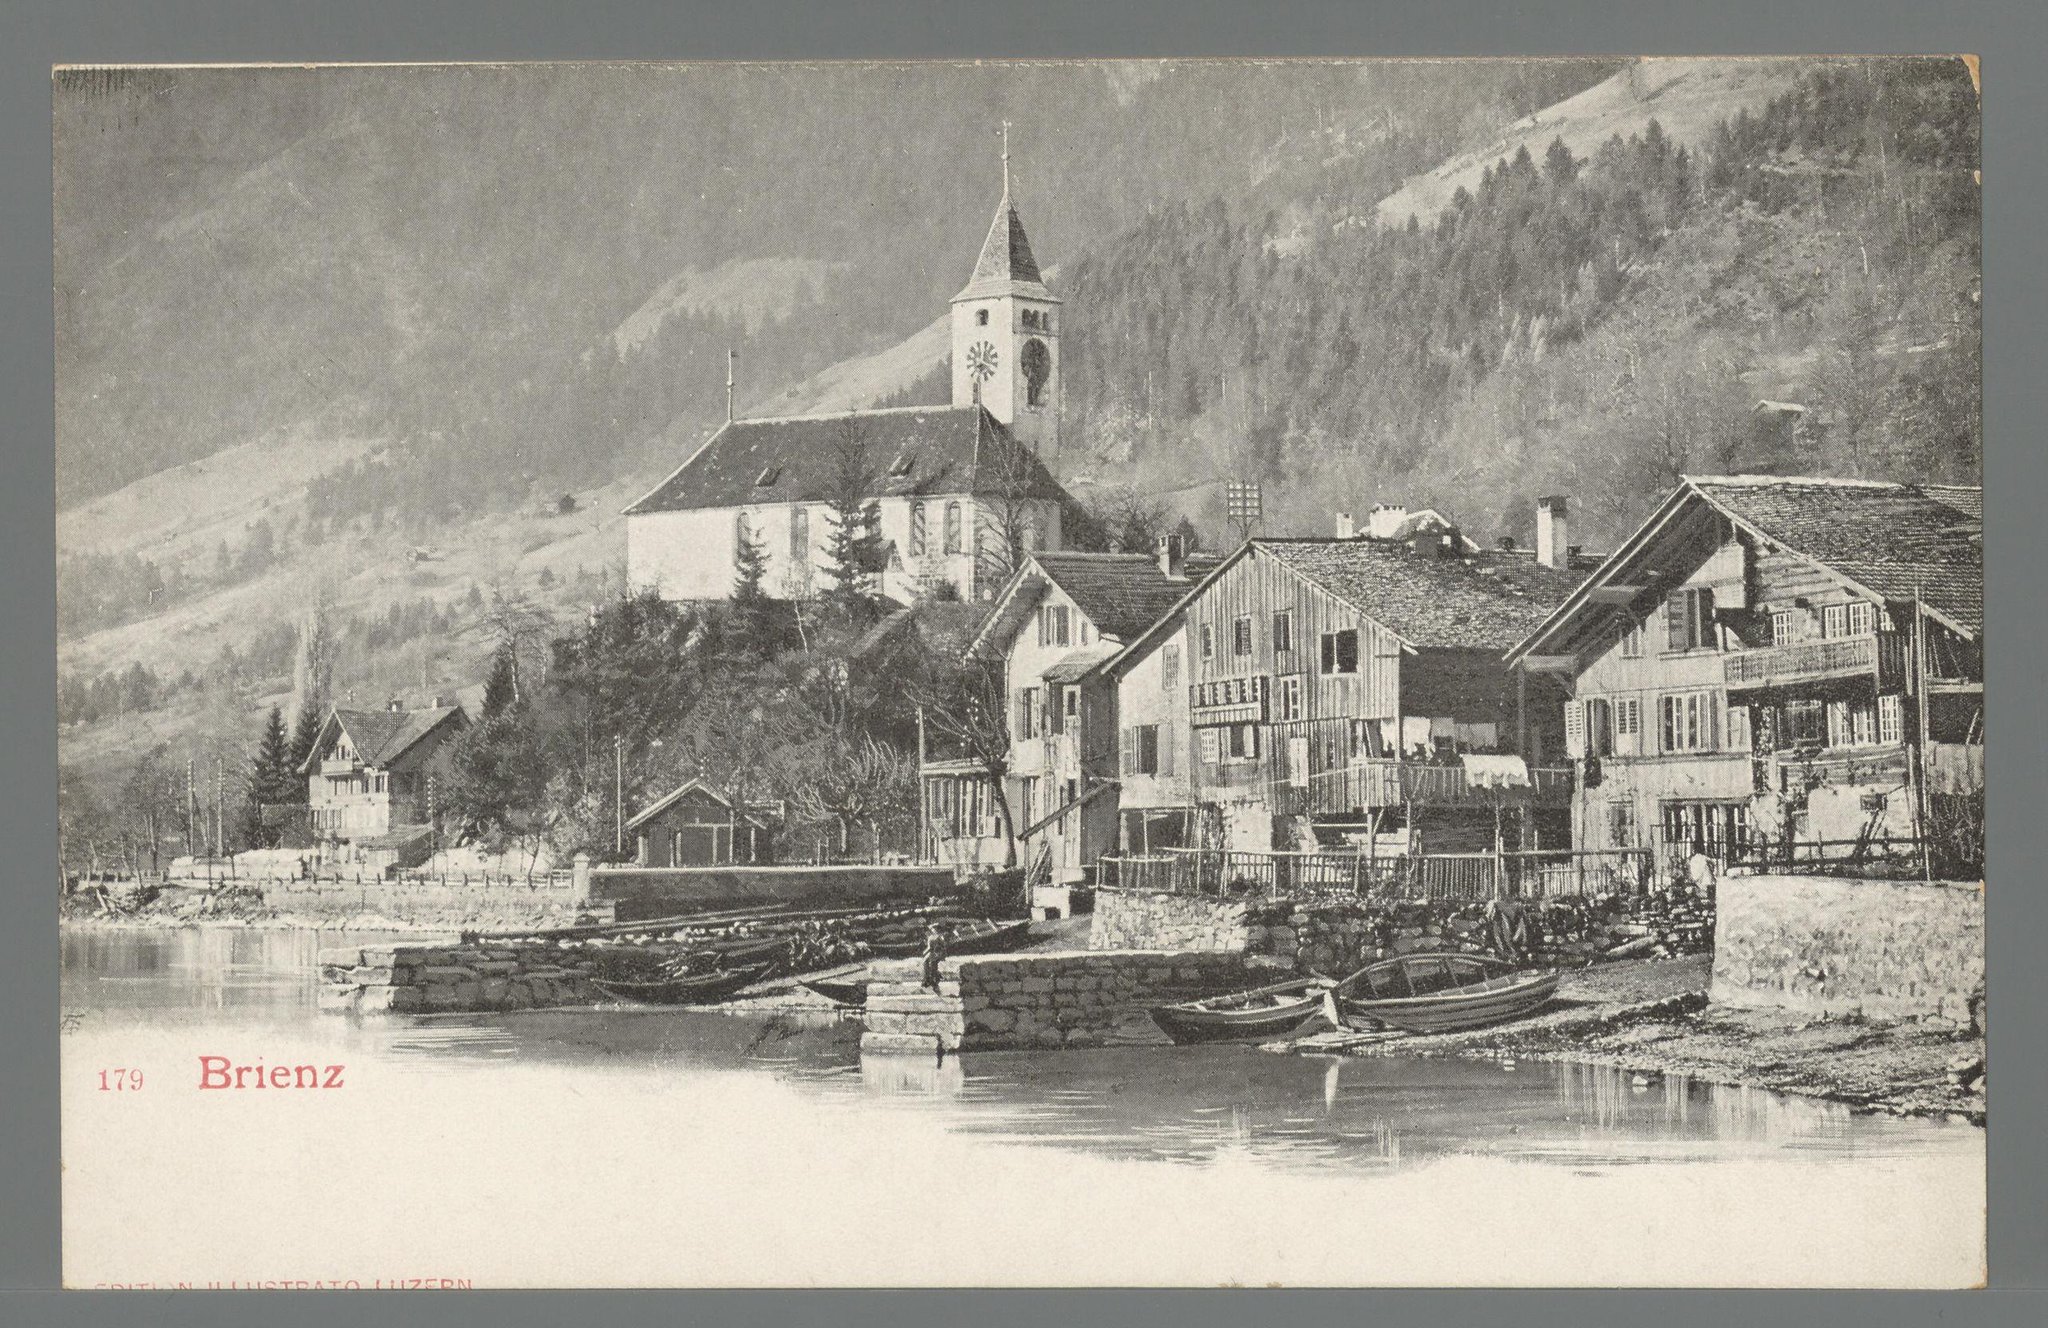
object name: photomechanical print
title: Brienz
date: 1890-1904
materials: cardboard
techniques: autotype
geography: brienz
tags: prospect of village, silhouette of village, church (exterior), prospect of village, silhouette of village (+ city(-scape) with figures, staffage)